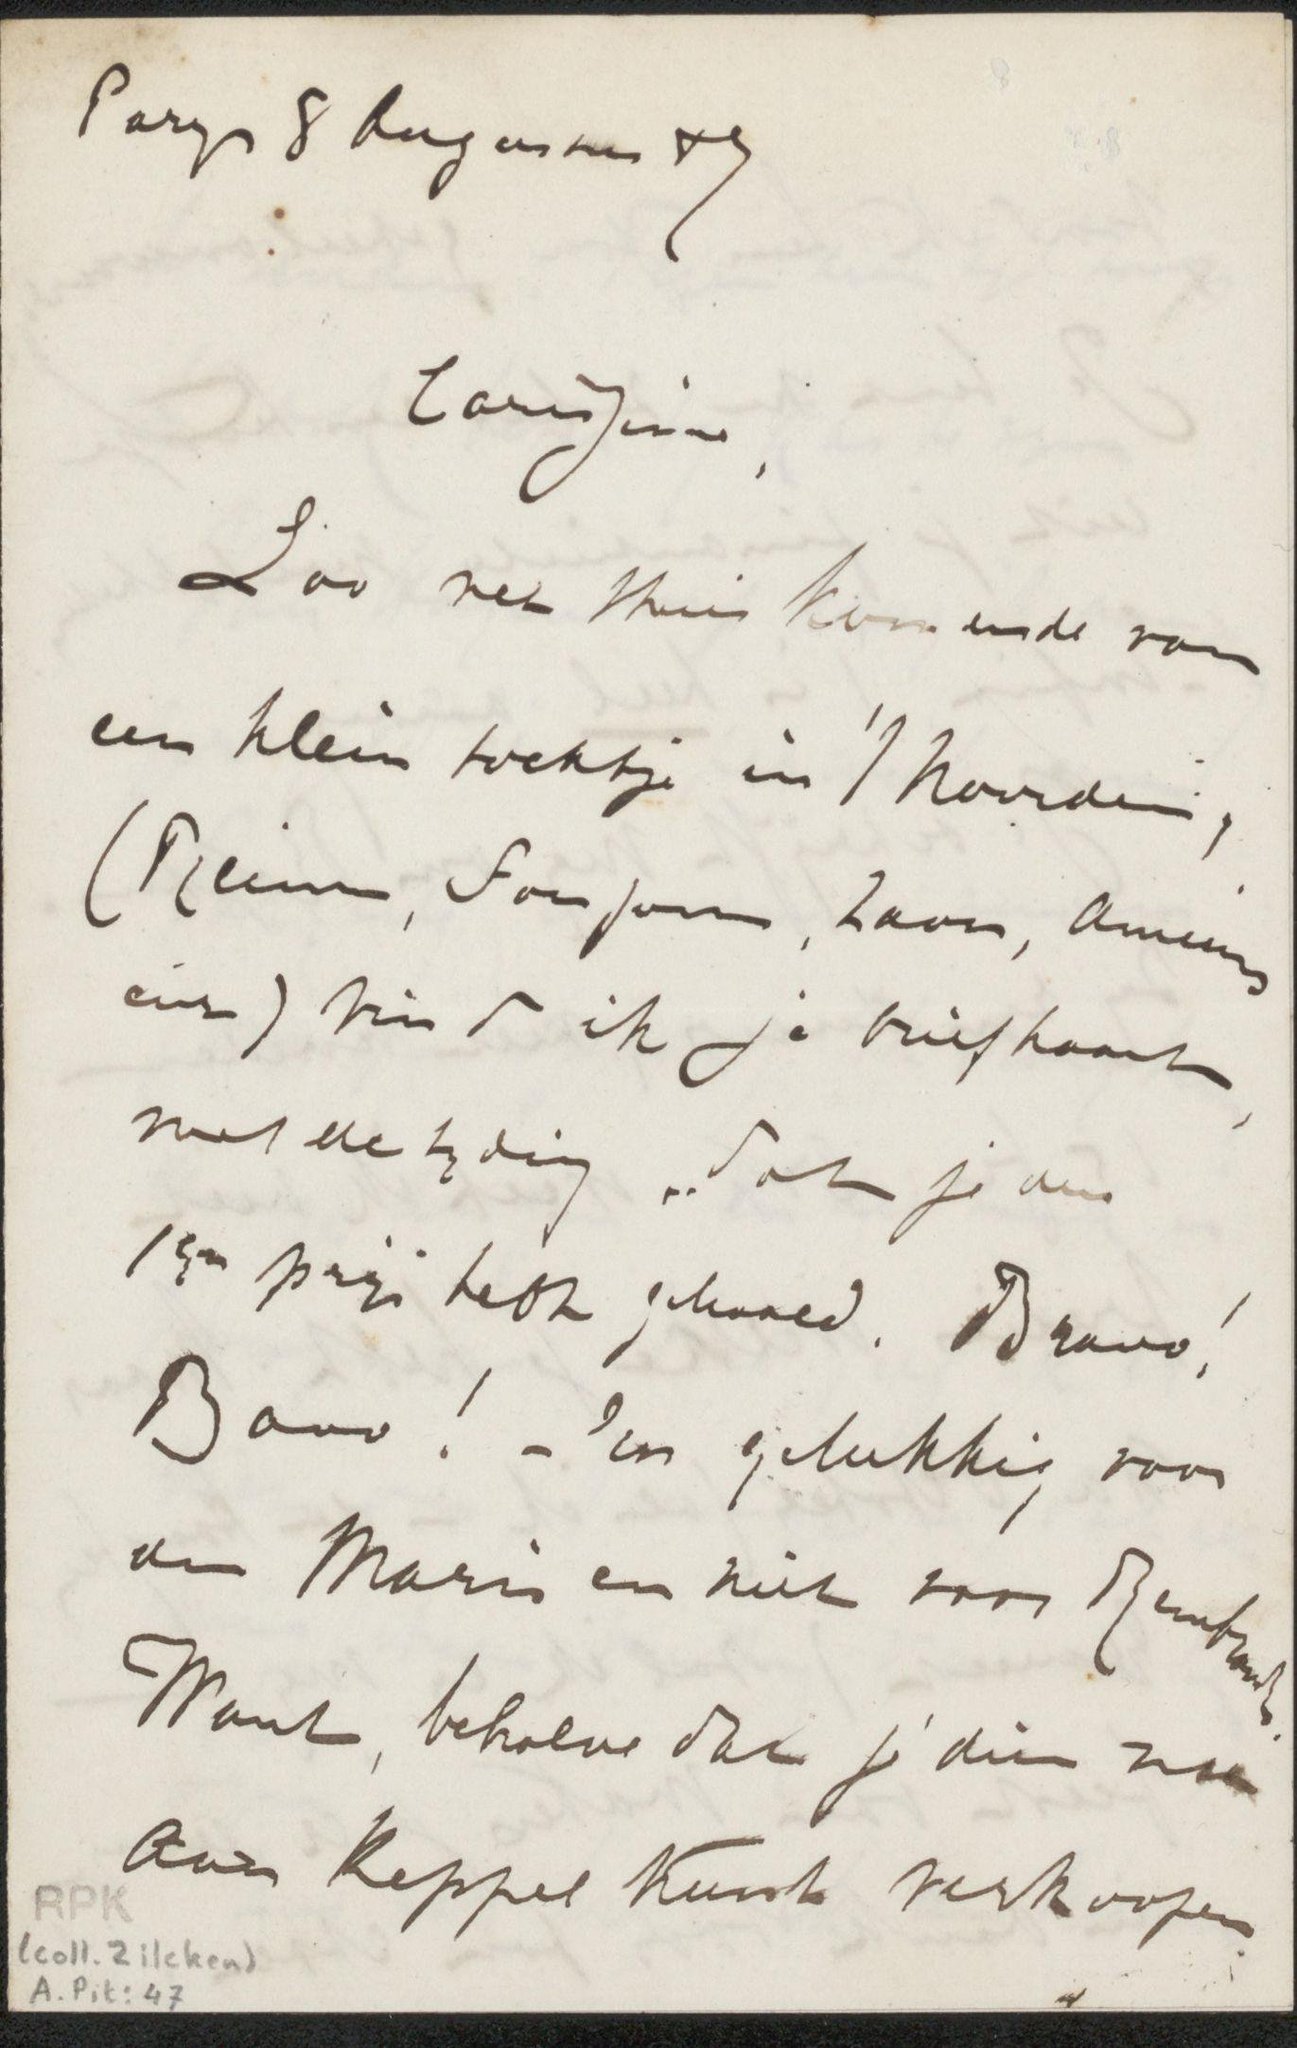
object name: letter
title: Brief aan Philip Zilcken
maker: adriaan pit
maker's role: print maker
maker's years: 1860-1944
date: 1887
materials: ink, paper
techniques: pen, writing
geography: paris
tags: london, matthijs maris, marinus van der maarel, print maker, alexis forel, amsterdam, painter, draughtsman, rembrandt van rijn, frederick keppel, frederik baron van hogendorp, philip zilcken, distribution of awards ~ art contest, the graphic arts, travelling; tourism, money, paris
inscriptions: watermark, collector's mark: ‘RPK’